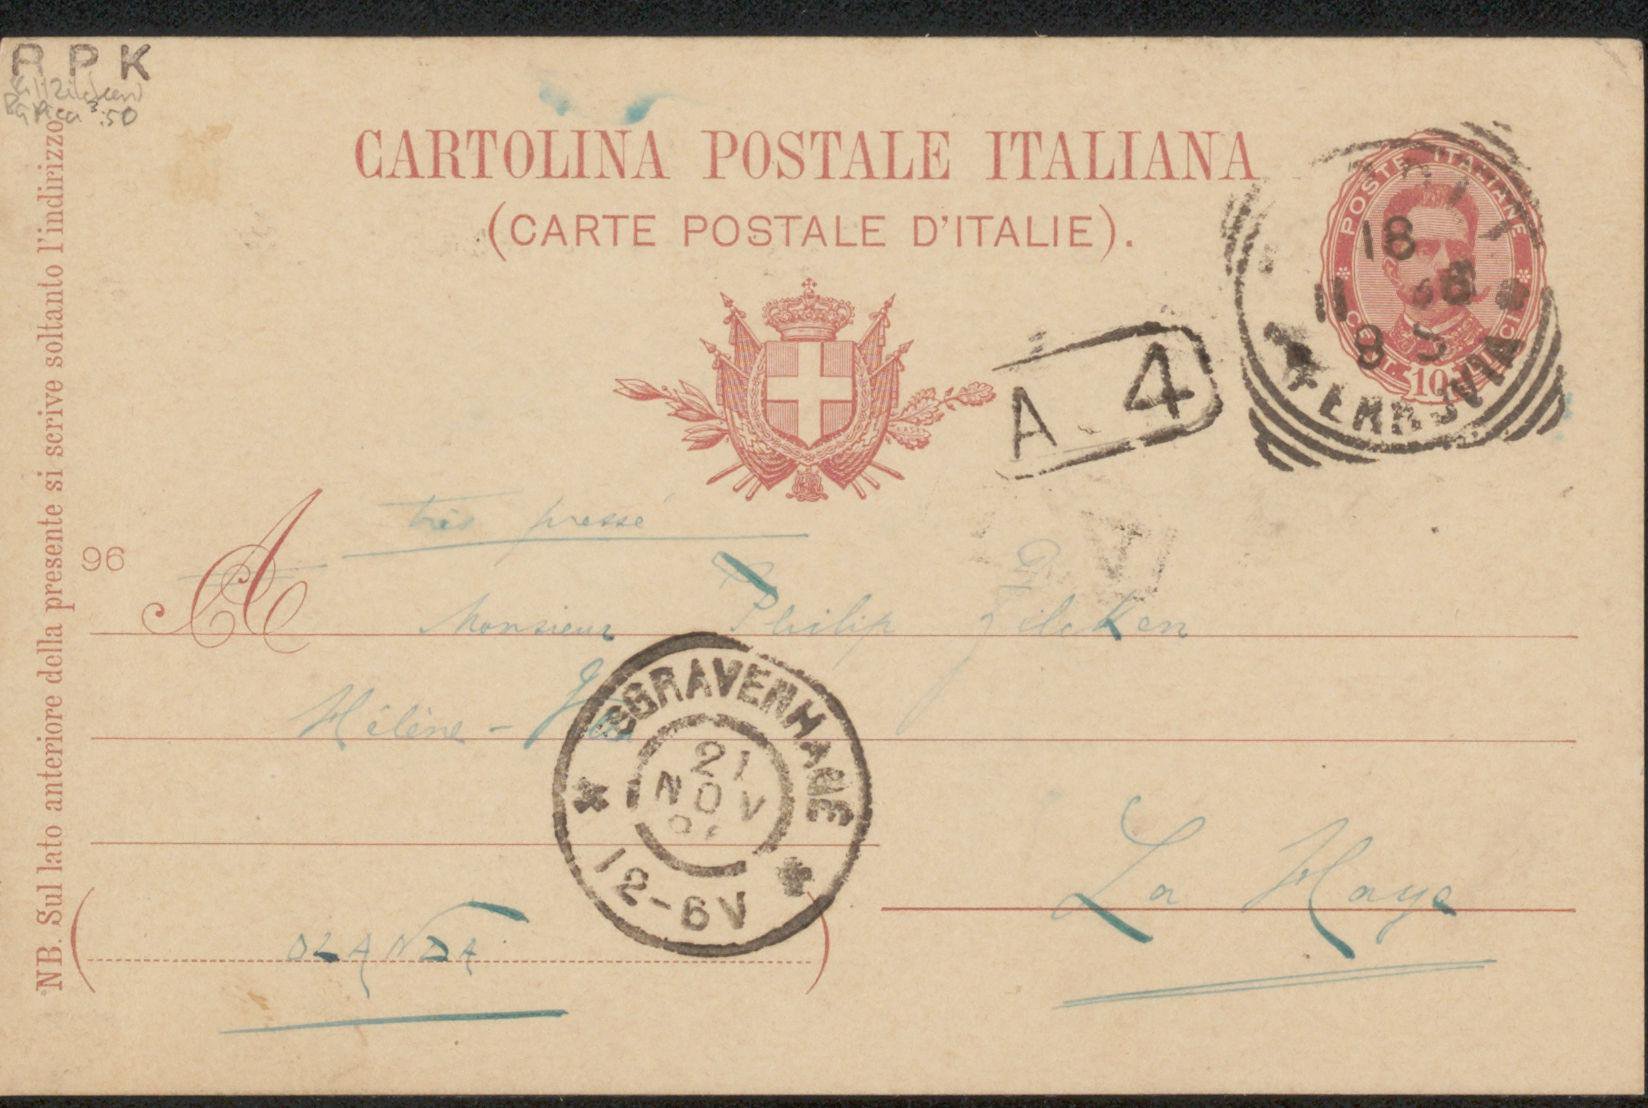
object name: postcard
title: Briefkaart aan Philip Zilcken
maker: vittorio pica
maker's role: criticus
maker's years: 1864-1930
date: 1896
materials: cardboard, ink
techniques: pen, writing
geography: naples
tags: draughtsman, philip zilcken, the graphic arts, printed matter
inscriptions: collector's mark: ‘RPK’